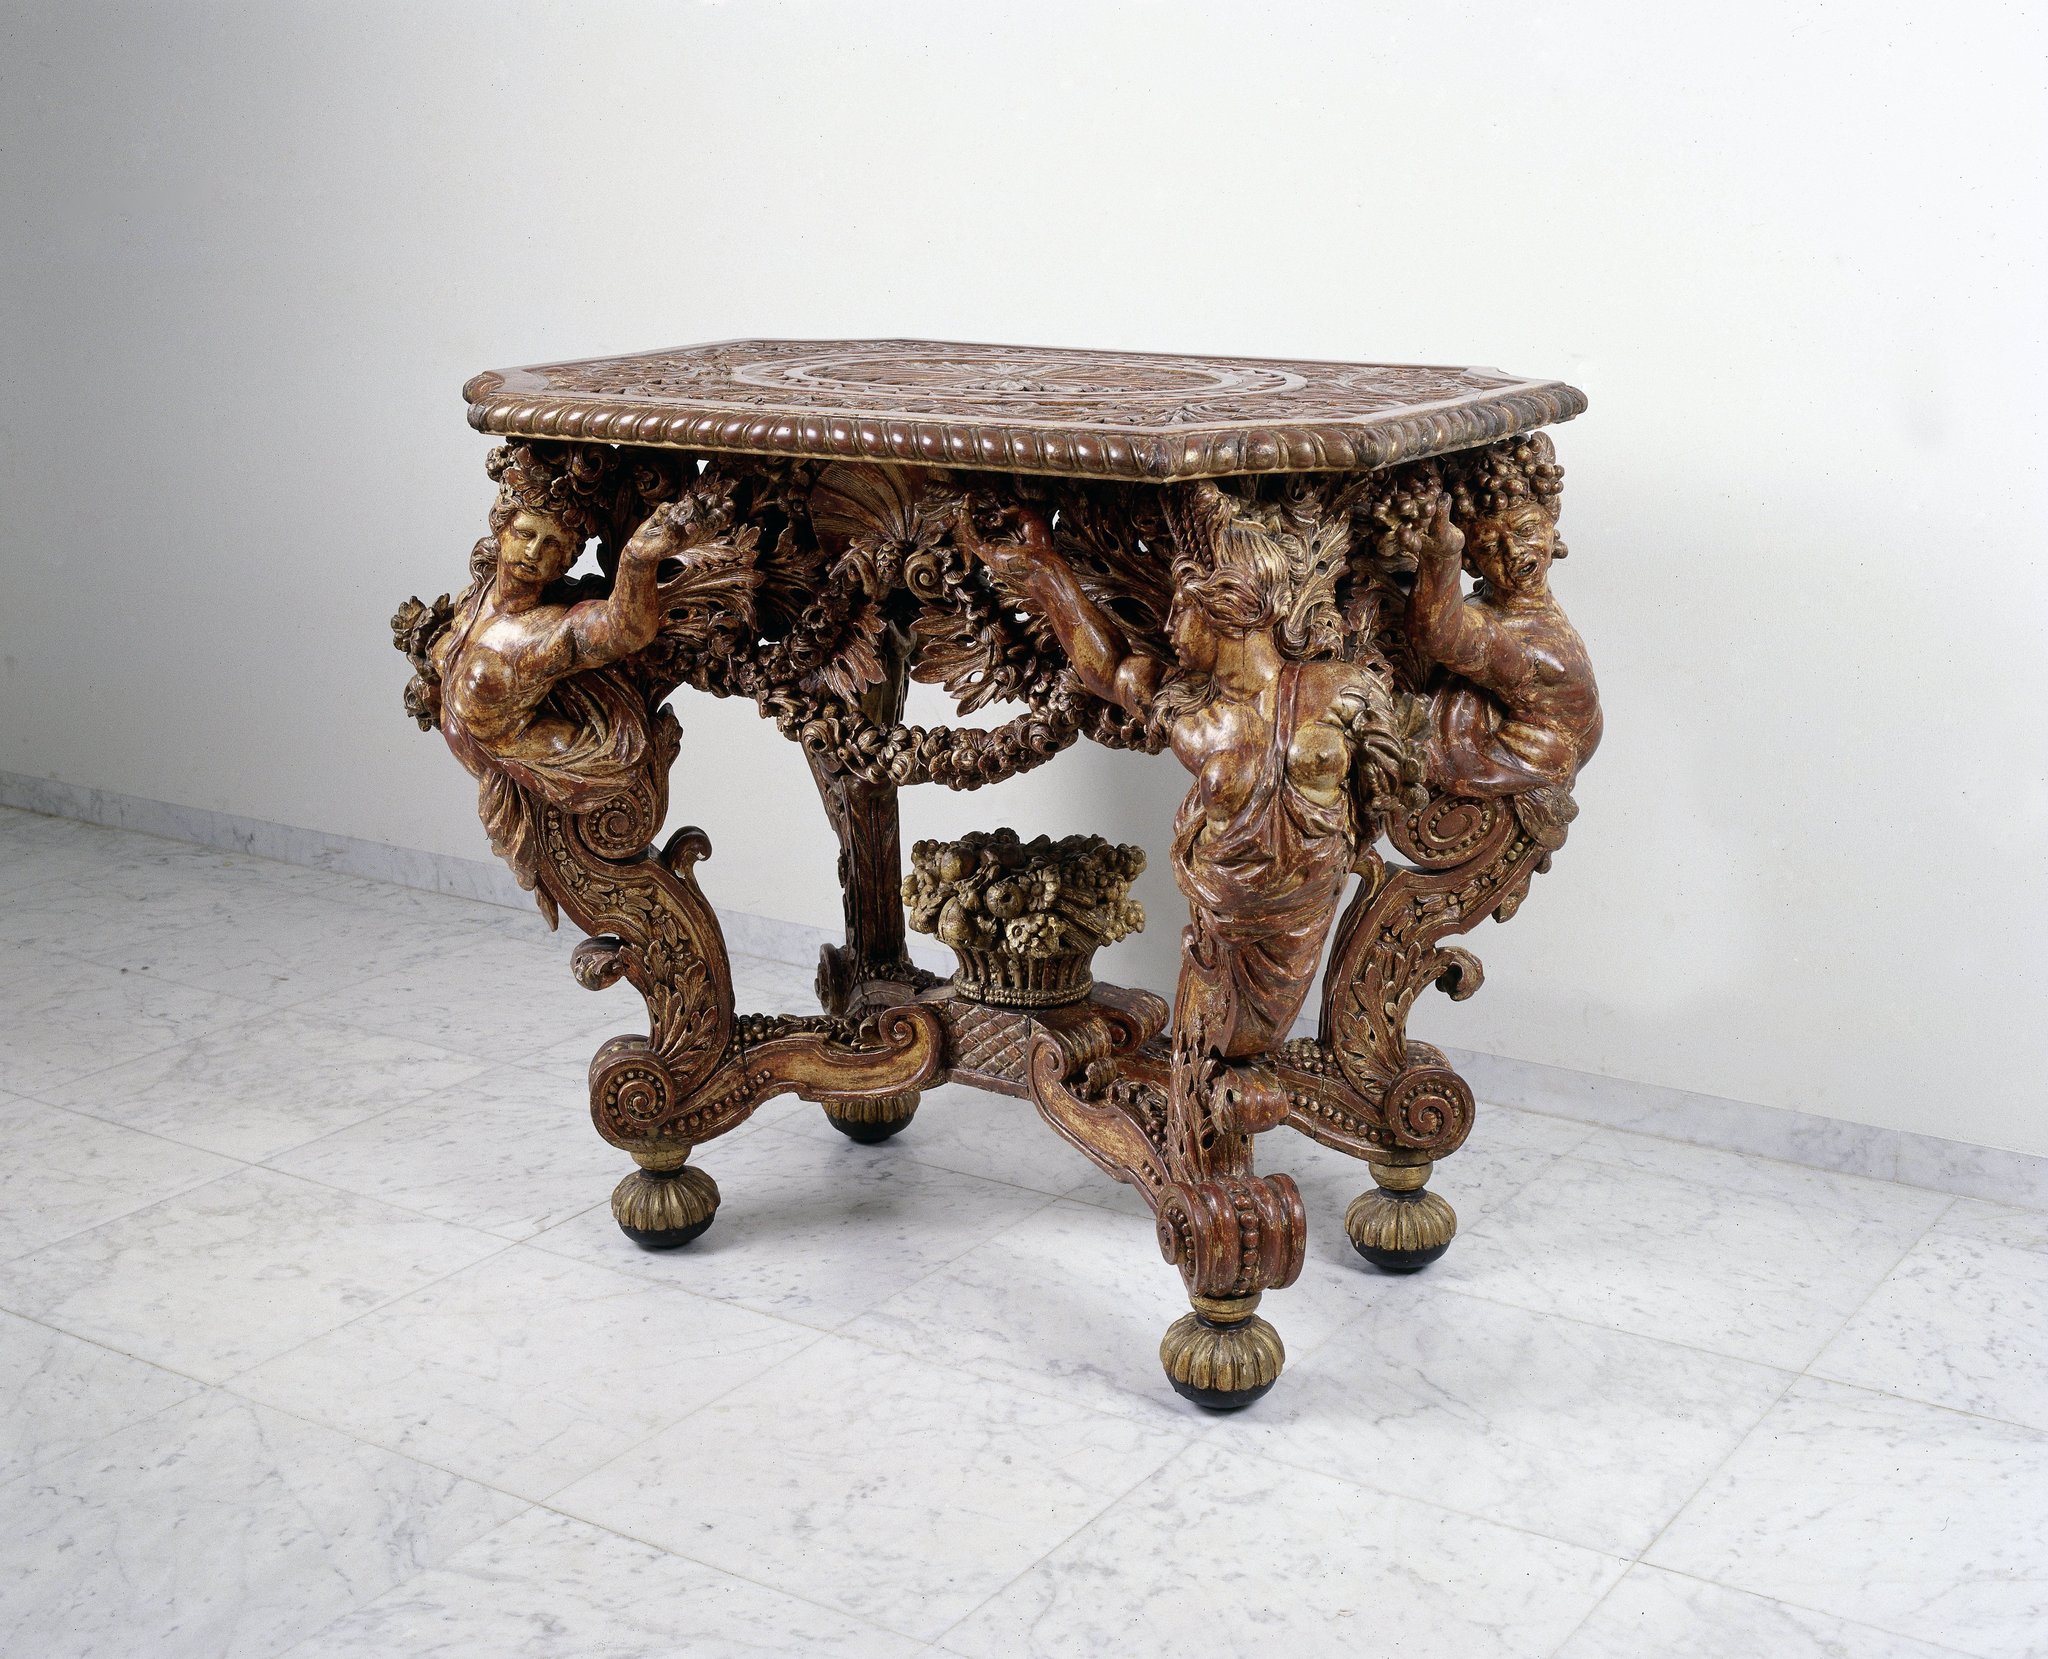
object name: wandtafel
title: Console table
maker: Anonymous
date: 1700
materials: wood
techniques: gilding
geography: the hague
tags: constructive (architectural) parts ~ human beings, seasons of the year (esp. personifications); 'stagione', 'le quattro stagione dell'anno' (ripa), still life of plants, flowers and fruit, ornament ~ festoon, garland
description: The four legs of this table represent the Four Seasons. Because it is a console table meant to be placed against a wall, the two back figures are turned towards the front. The gilding of the table is very worn, so the red underlayer shows through in places. Originally, the piece must have looked as if it was made of gold, or silver gilt.